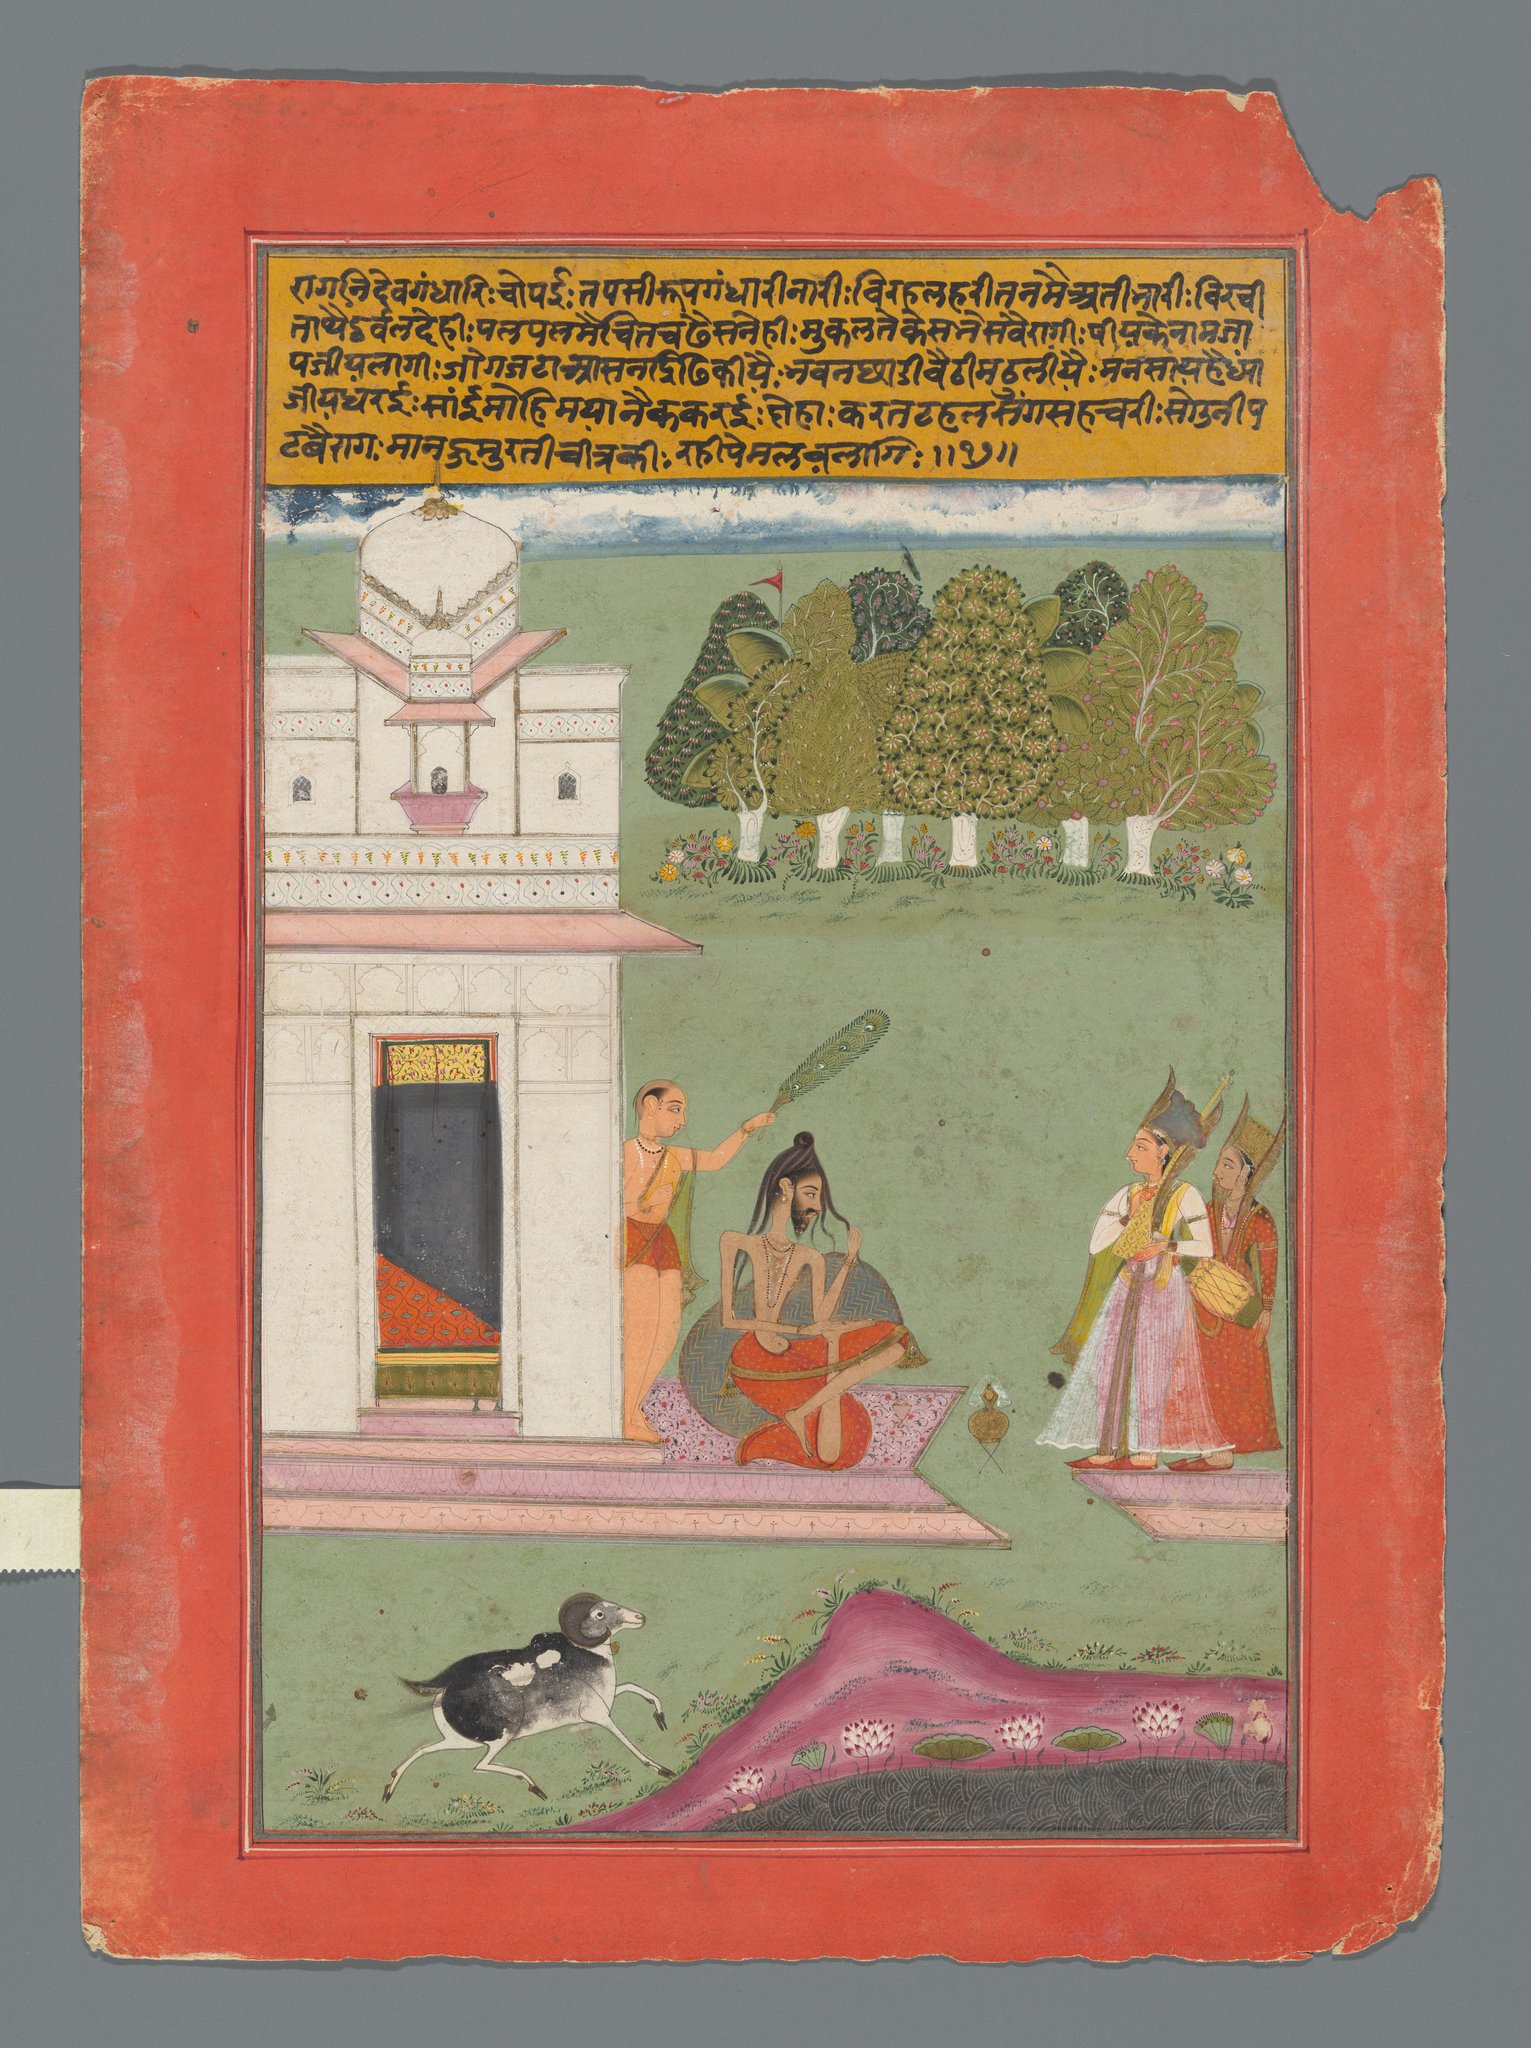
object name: indian miniature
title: Devagandhari Ragini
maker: Anonymous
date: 1700-1799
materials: paper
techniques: brush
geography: amber